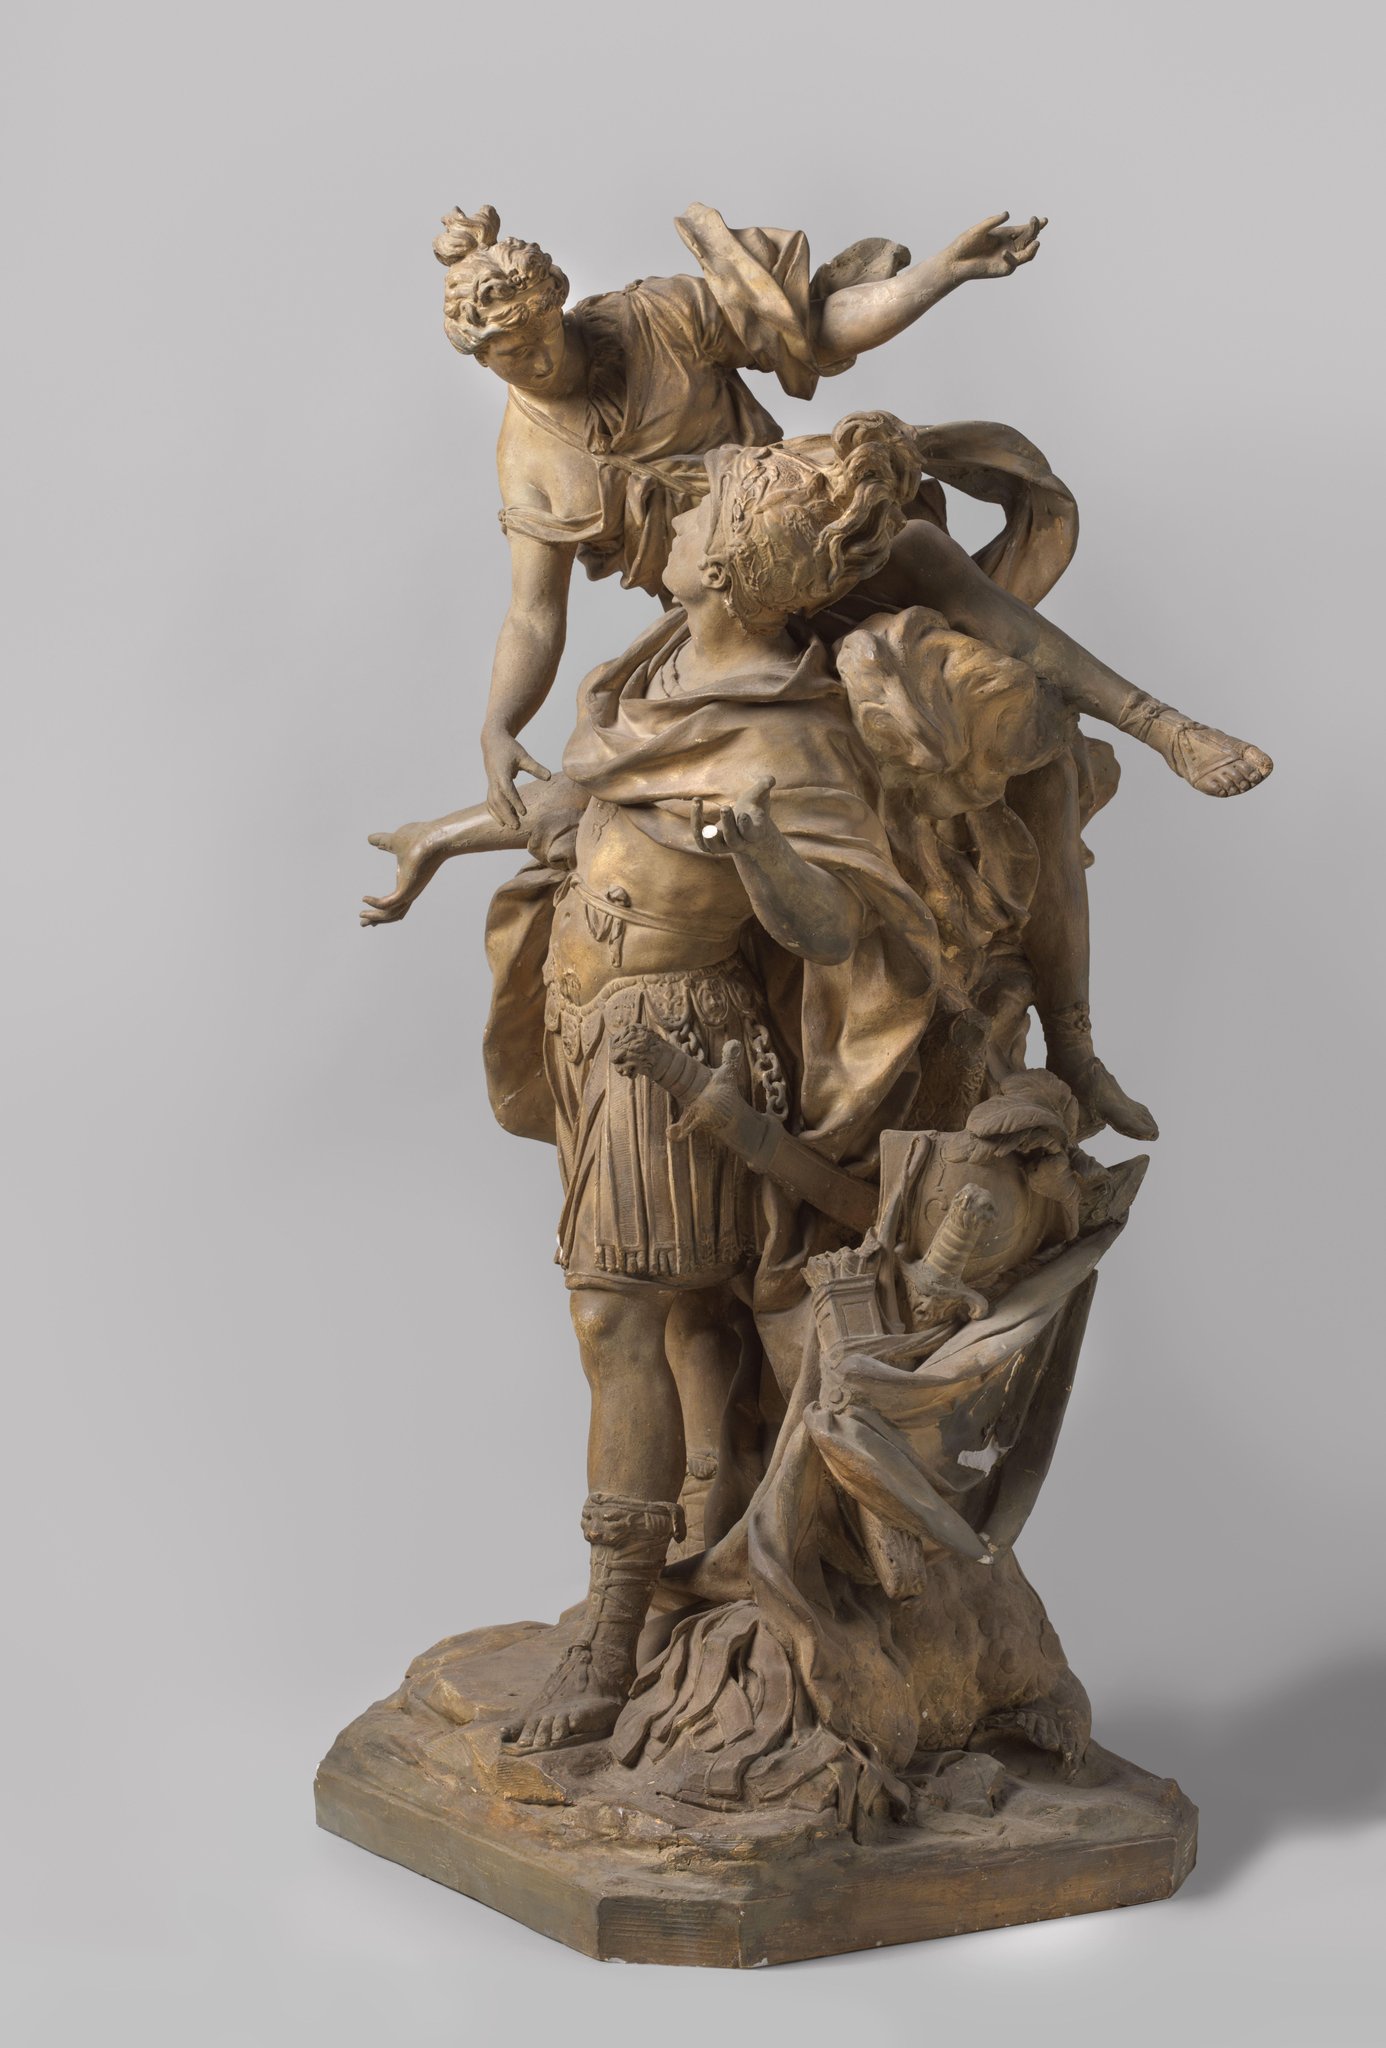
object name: sculpture group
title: Aeneas ontvangt wapens van Venus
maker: jean cornu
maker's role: sculptor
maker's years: 1650-1710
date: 1704-1710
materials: gypsum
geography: france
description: Beeldengroep op vrijwel vierkante plint met afgeschuinde hoeken voorstellende een staande man in Romeins harnas. Rechts achter hem, zwevend, een vrouw in antieke dracht. Aan zijn voeten een rotsgrond met opgestapeld wapentuig.